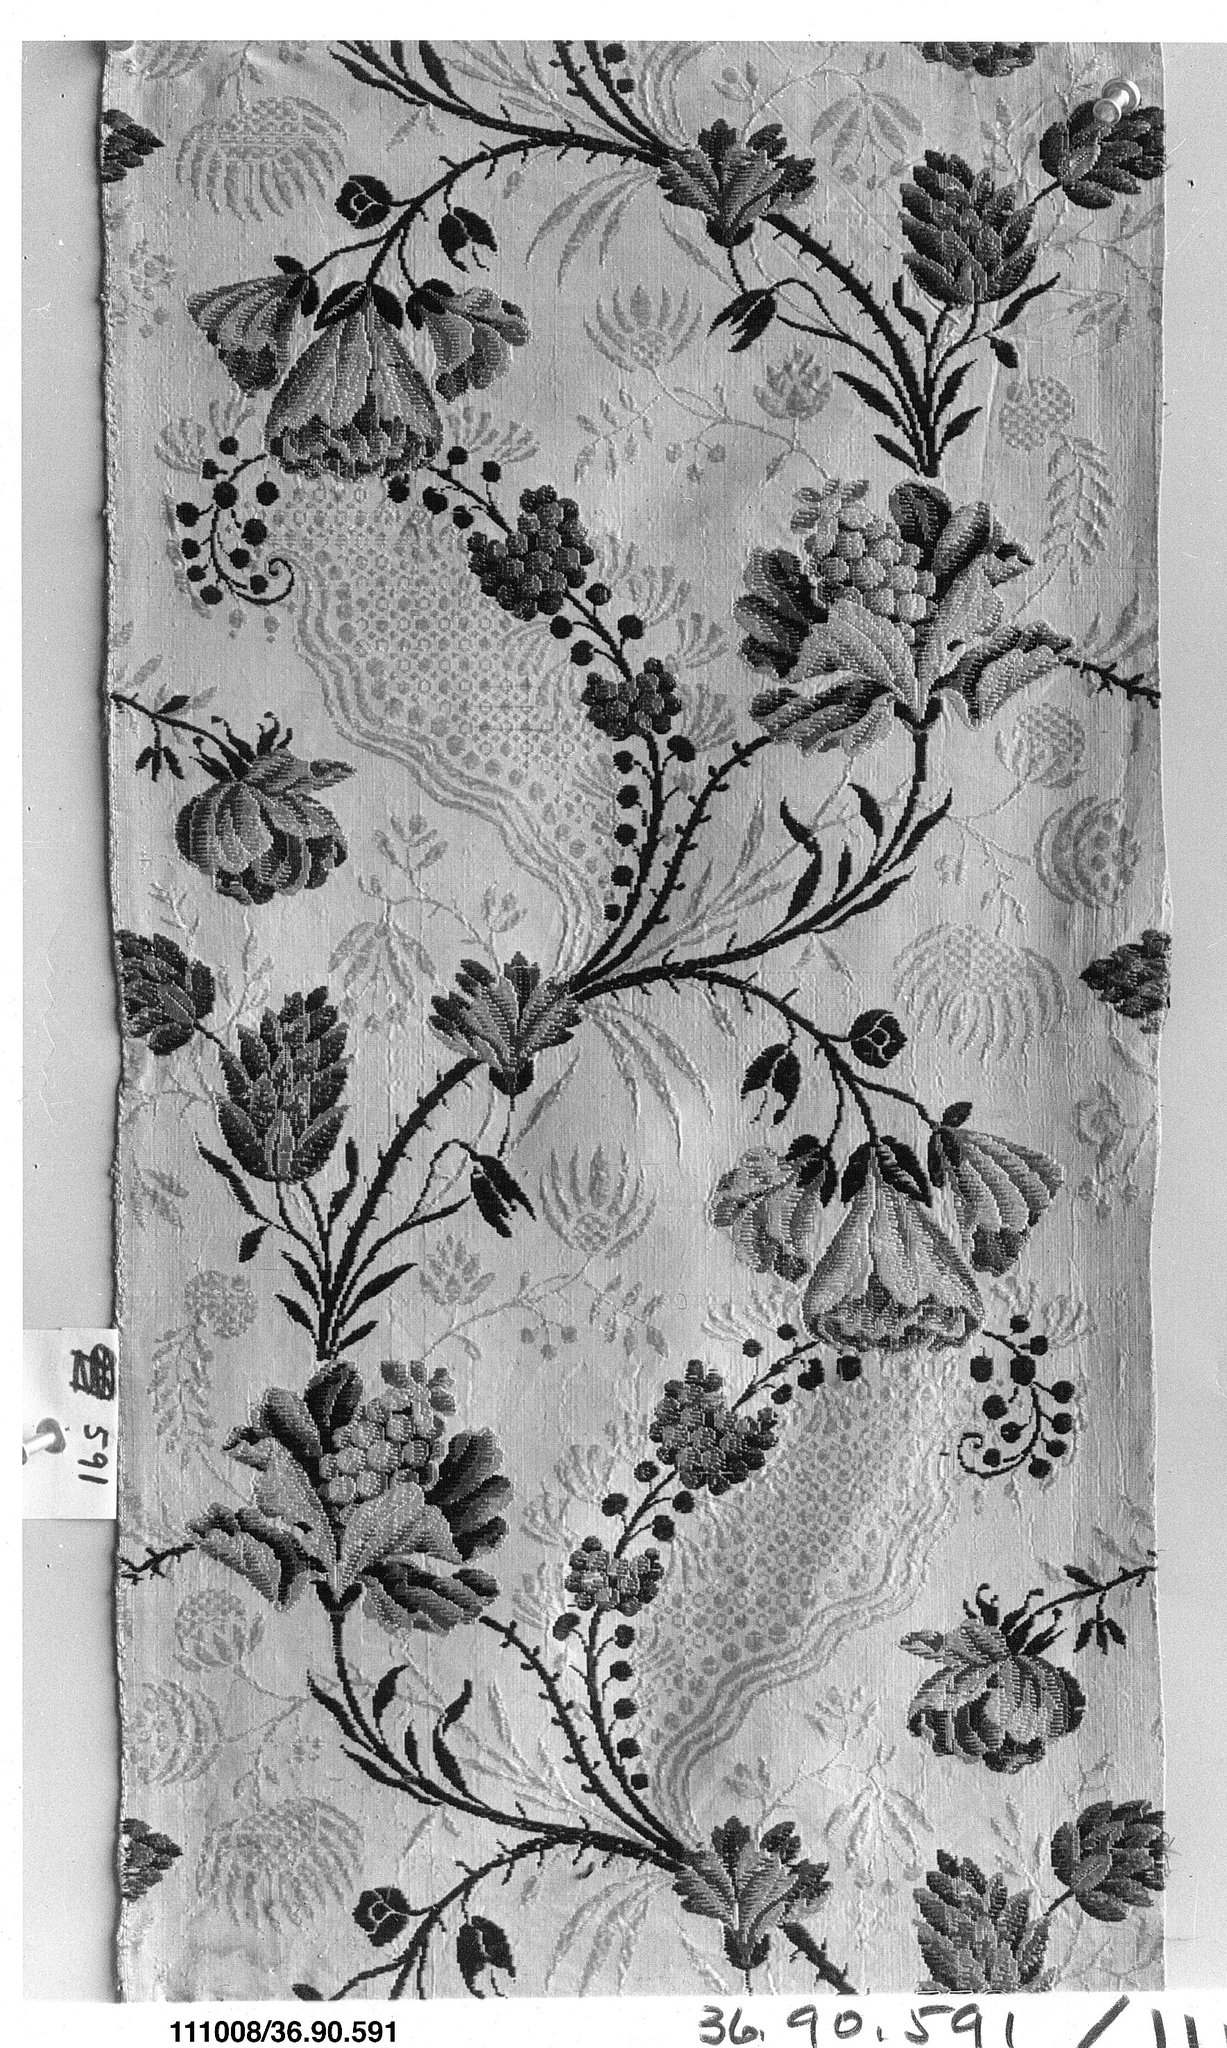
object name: piece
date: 1734-1766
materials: silk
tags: flowers